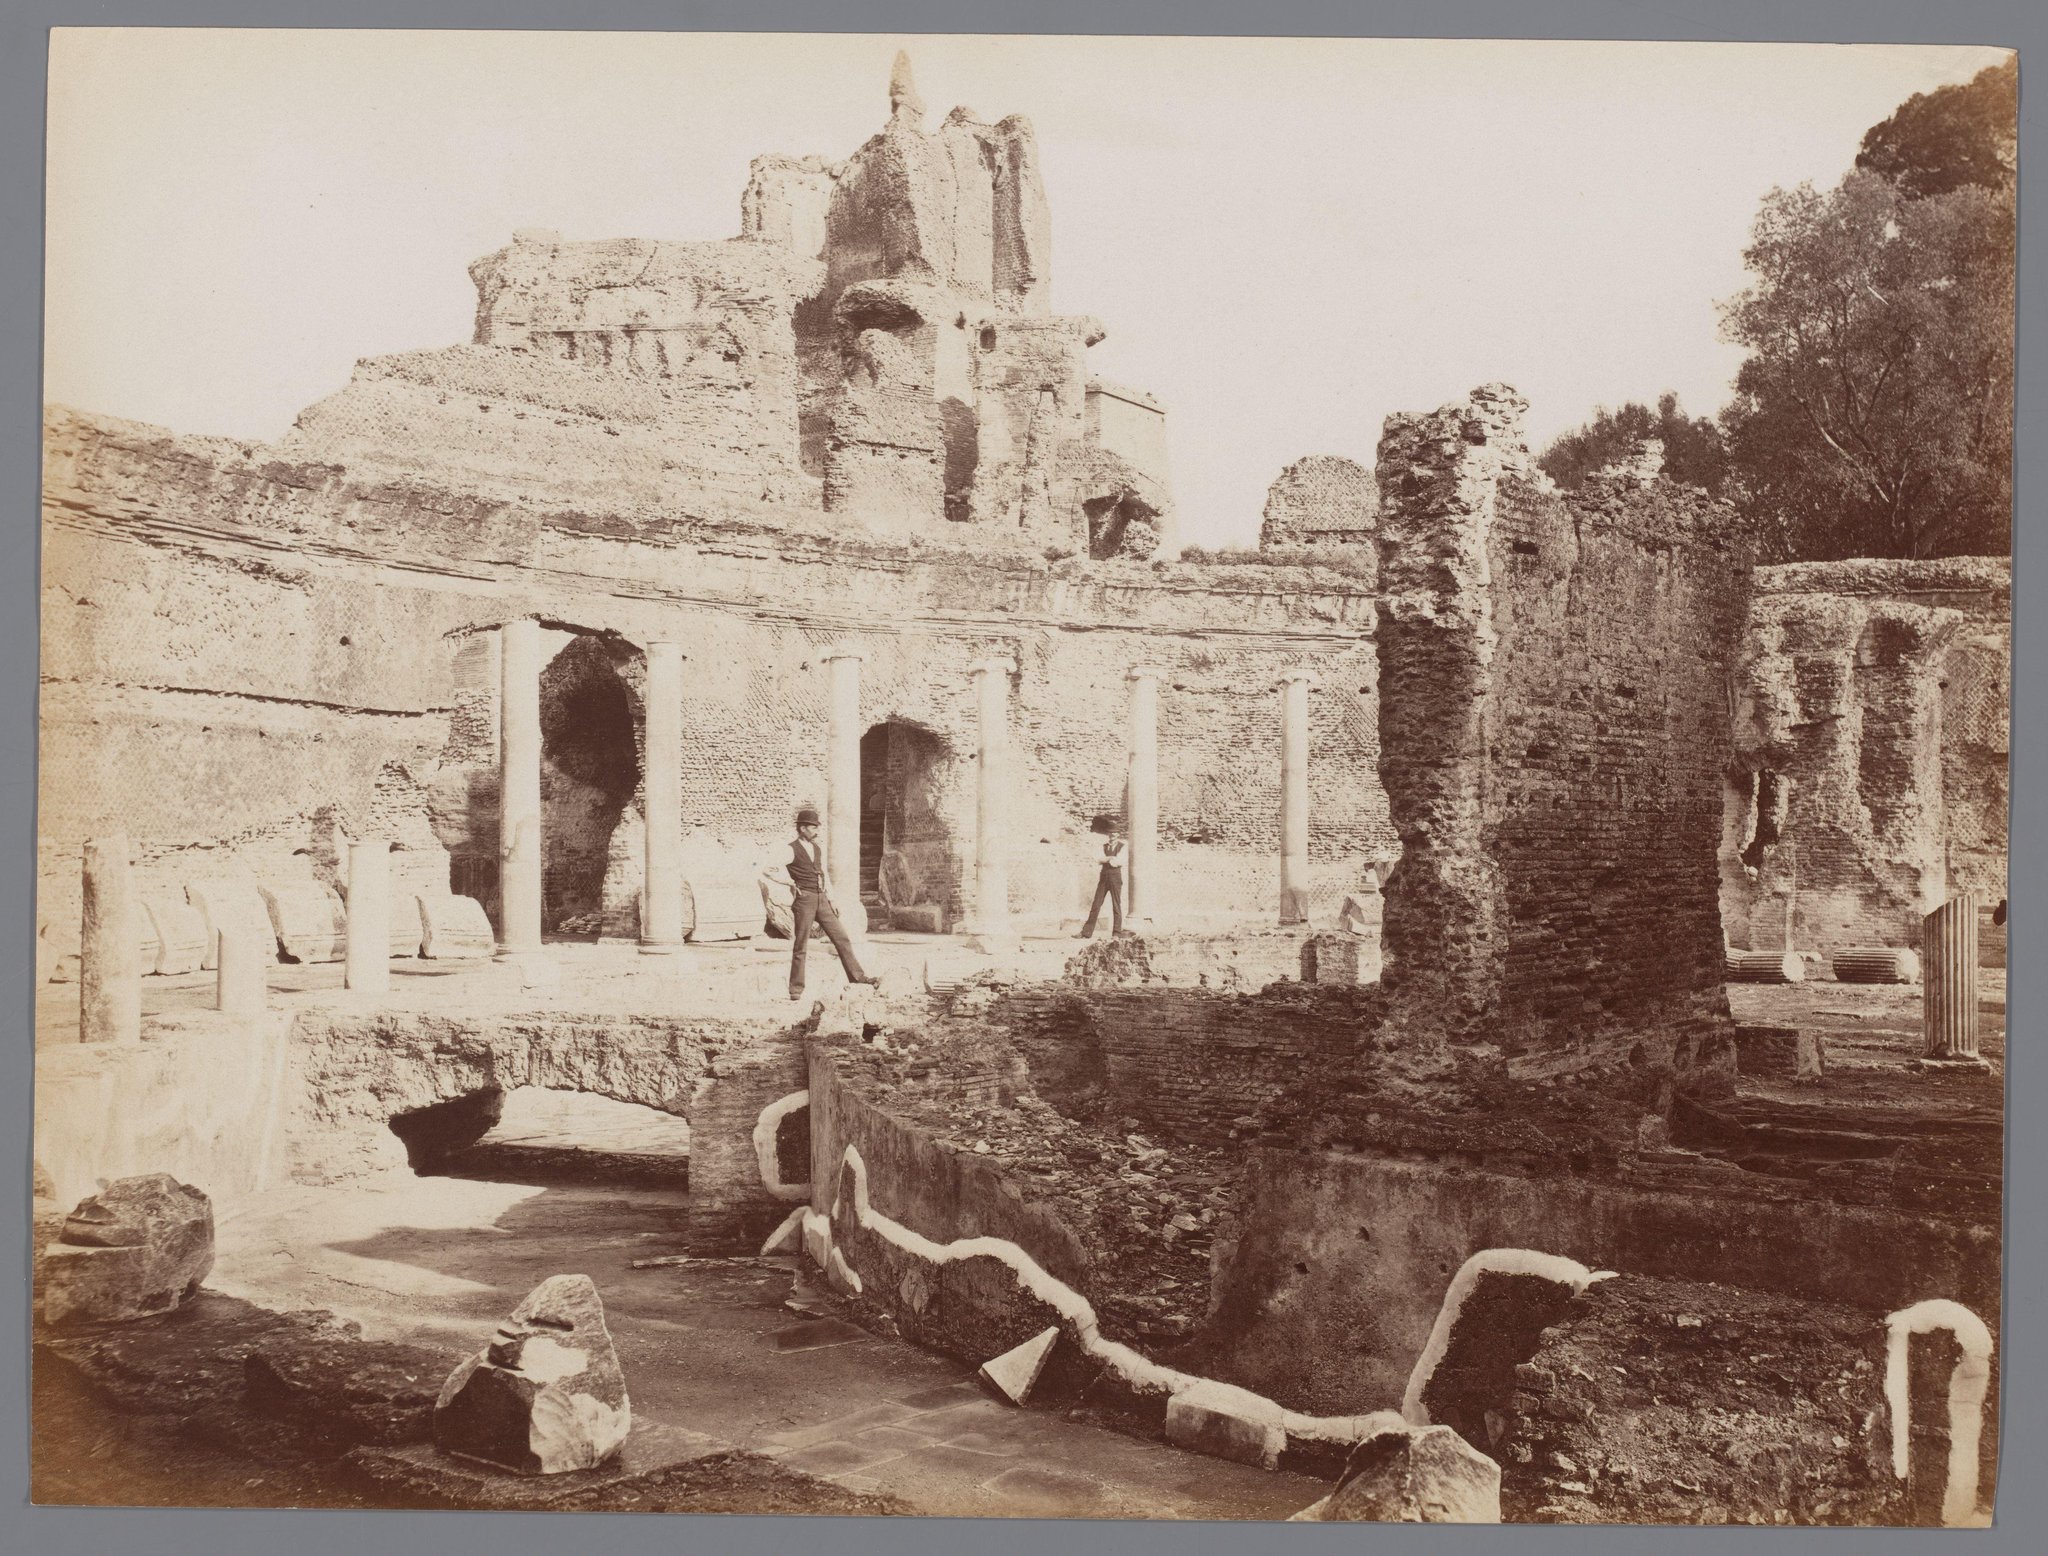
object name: photograph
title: Villa Adriana in Tivoli, Italië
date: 1860-1885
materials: photographic support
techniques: albumen print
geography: rome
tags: villa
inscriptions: name: ‘FOTOGRAFIA ANDERSON//ROMA’, inscription: ‘Villa Hadriani [sic] - Tivoli’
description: Villa van Hadrianus in Tivoli, blik op Maritiem Theater. Gezicht vanaf het zuiden op de thermen met Heliocaminus. Op de achtergrond de Biblioteca Greca.